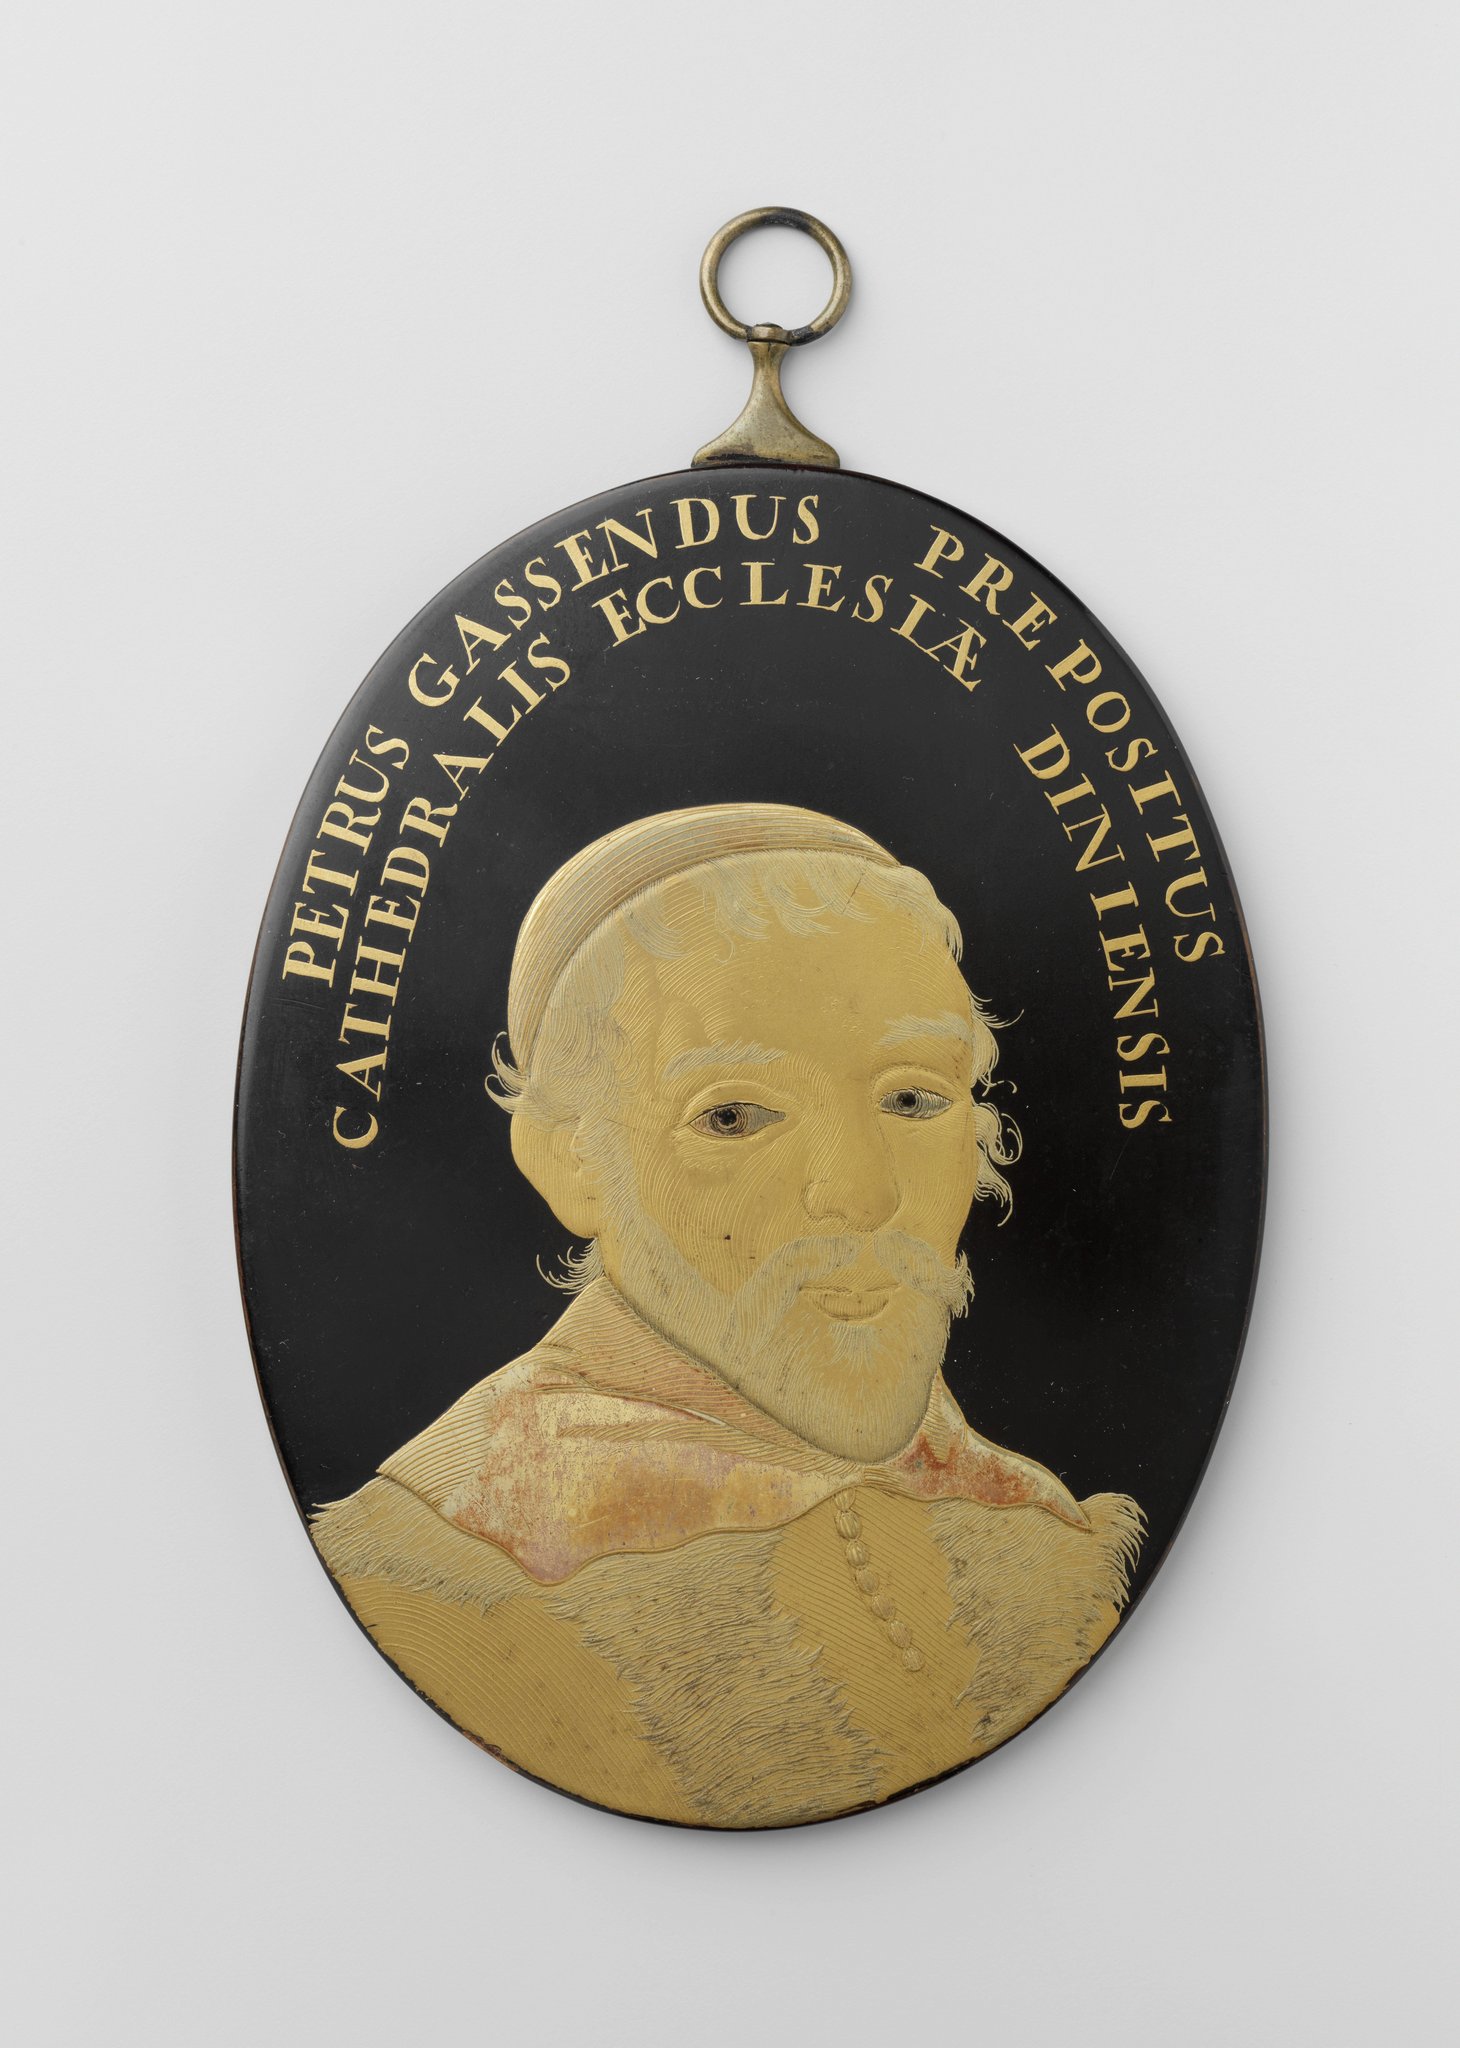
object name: plaque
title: Petrus Gassendus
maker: Anonymous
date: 1775-1800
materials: copper, gold, lacquer, paint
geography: japan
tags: priest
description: Portraits of European monarchs and scholars. Japan, last quarter 18th century. The VOC exported lacquer products commissioned specifically for the European market. Working from European prints, Japanese craftsmen made series of portraits for the VOC.